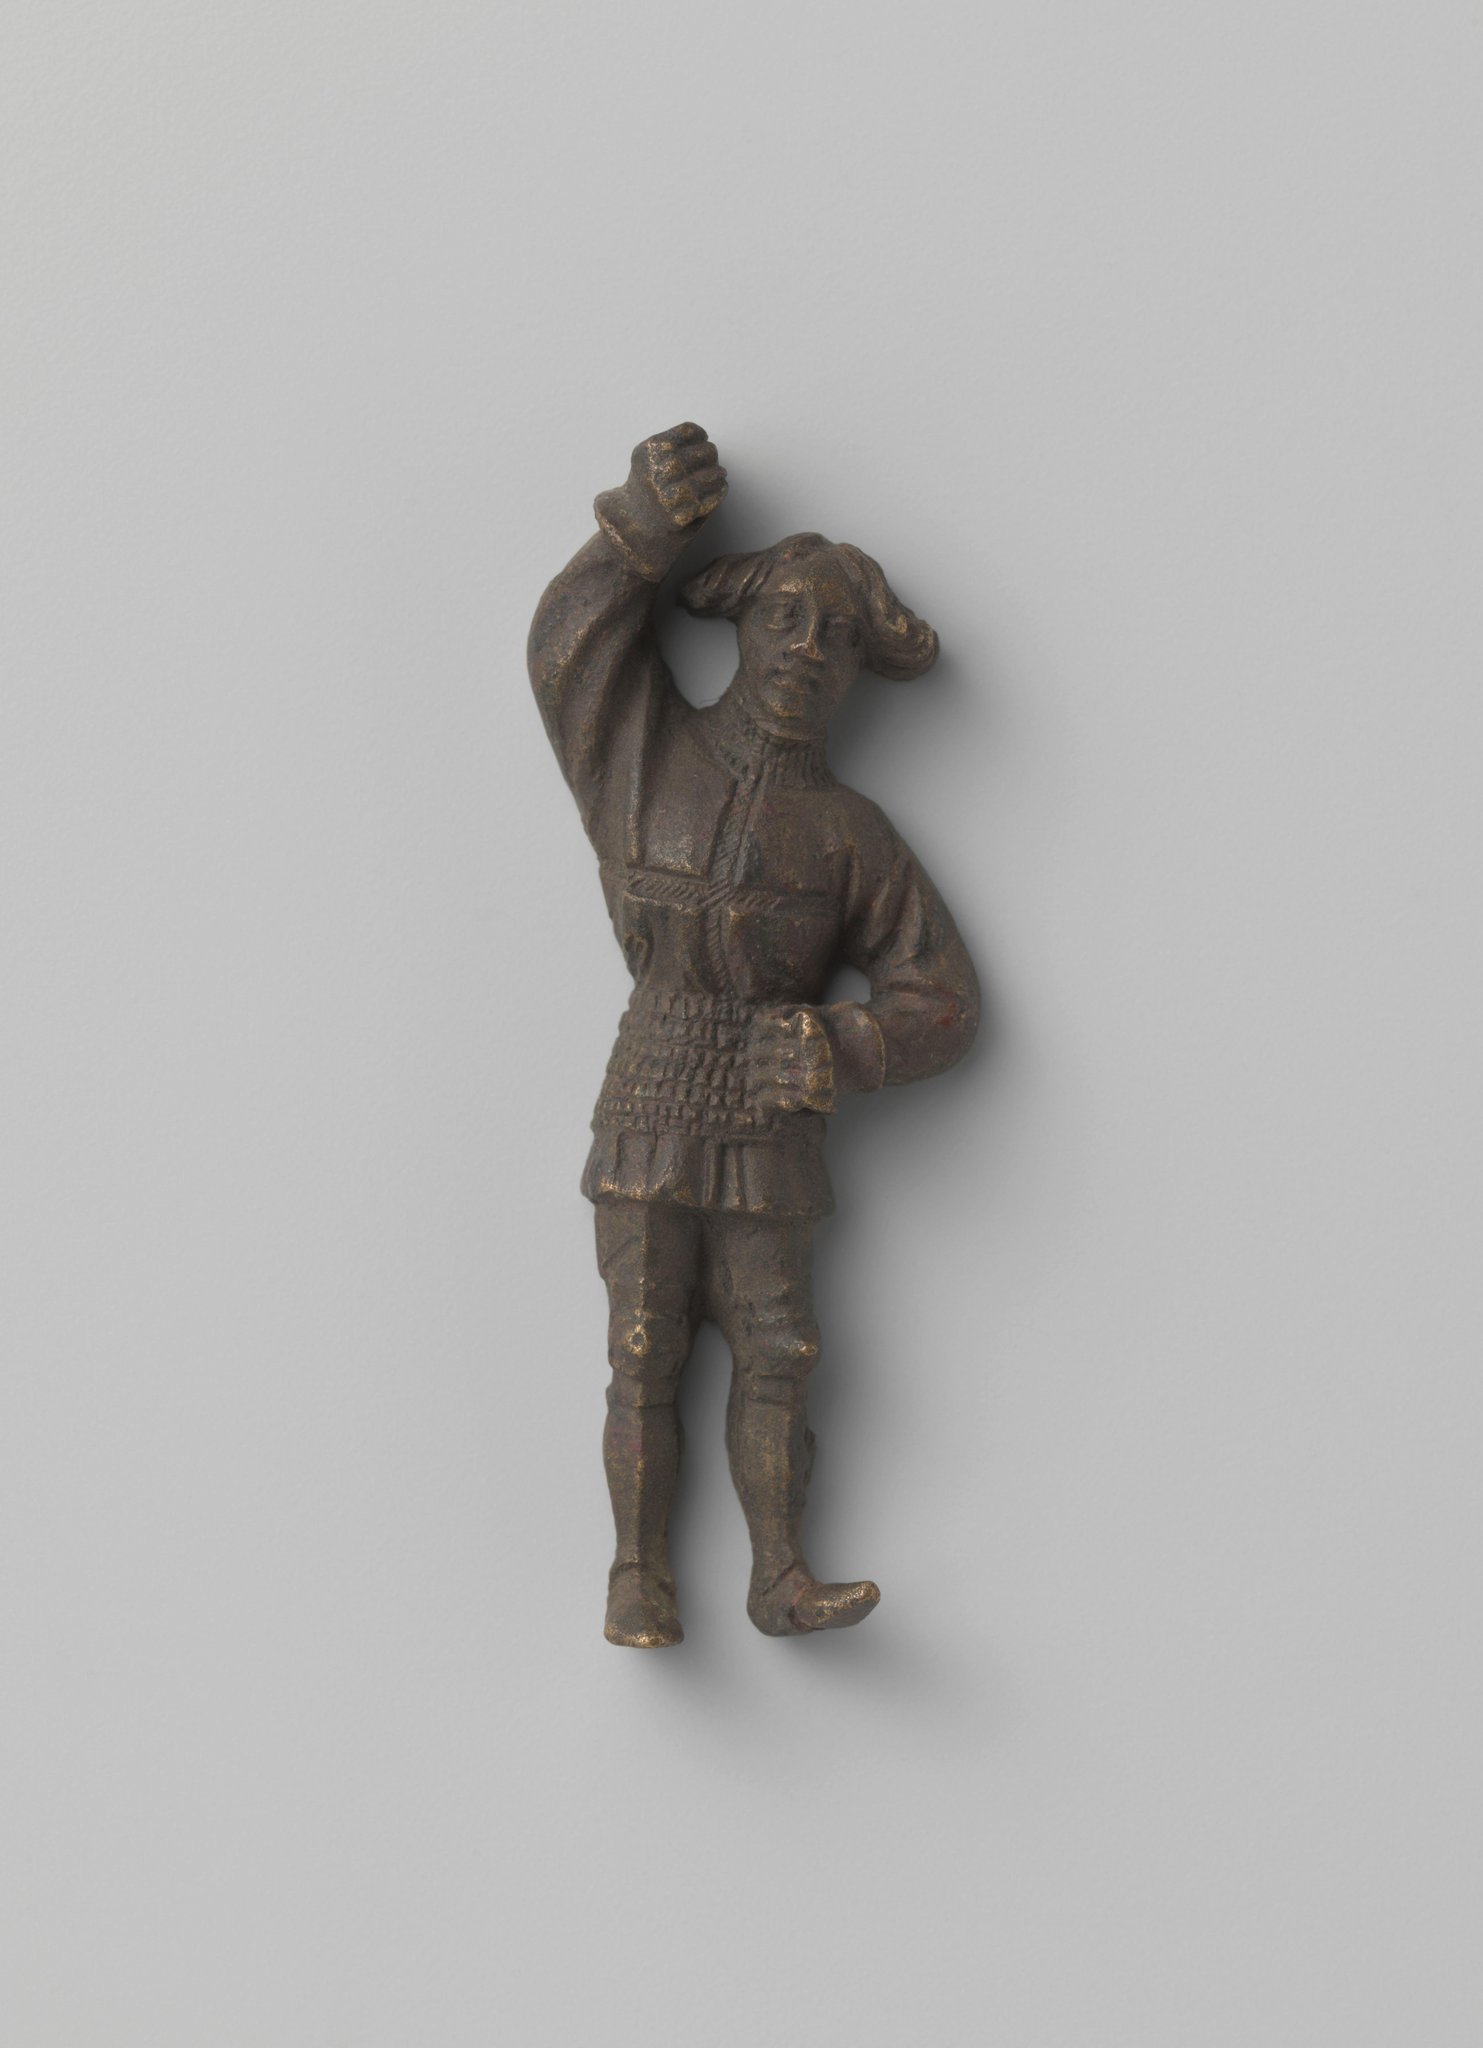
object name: figure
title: Ridder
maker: Anonymous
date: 1400-1500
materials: copper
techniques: casting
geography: western europe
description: De als één geheel gegoten, aan de achterkant platte ridderfiguur draagt een harnas. Zijn rechterarm houdt hij omhoog om met beide handen een lans te kunnen vasthouden. Deze ontbreekt. De functie van het voorwerp is onbekend.